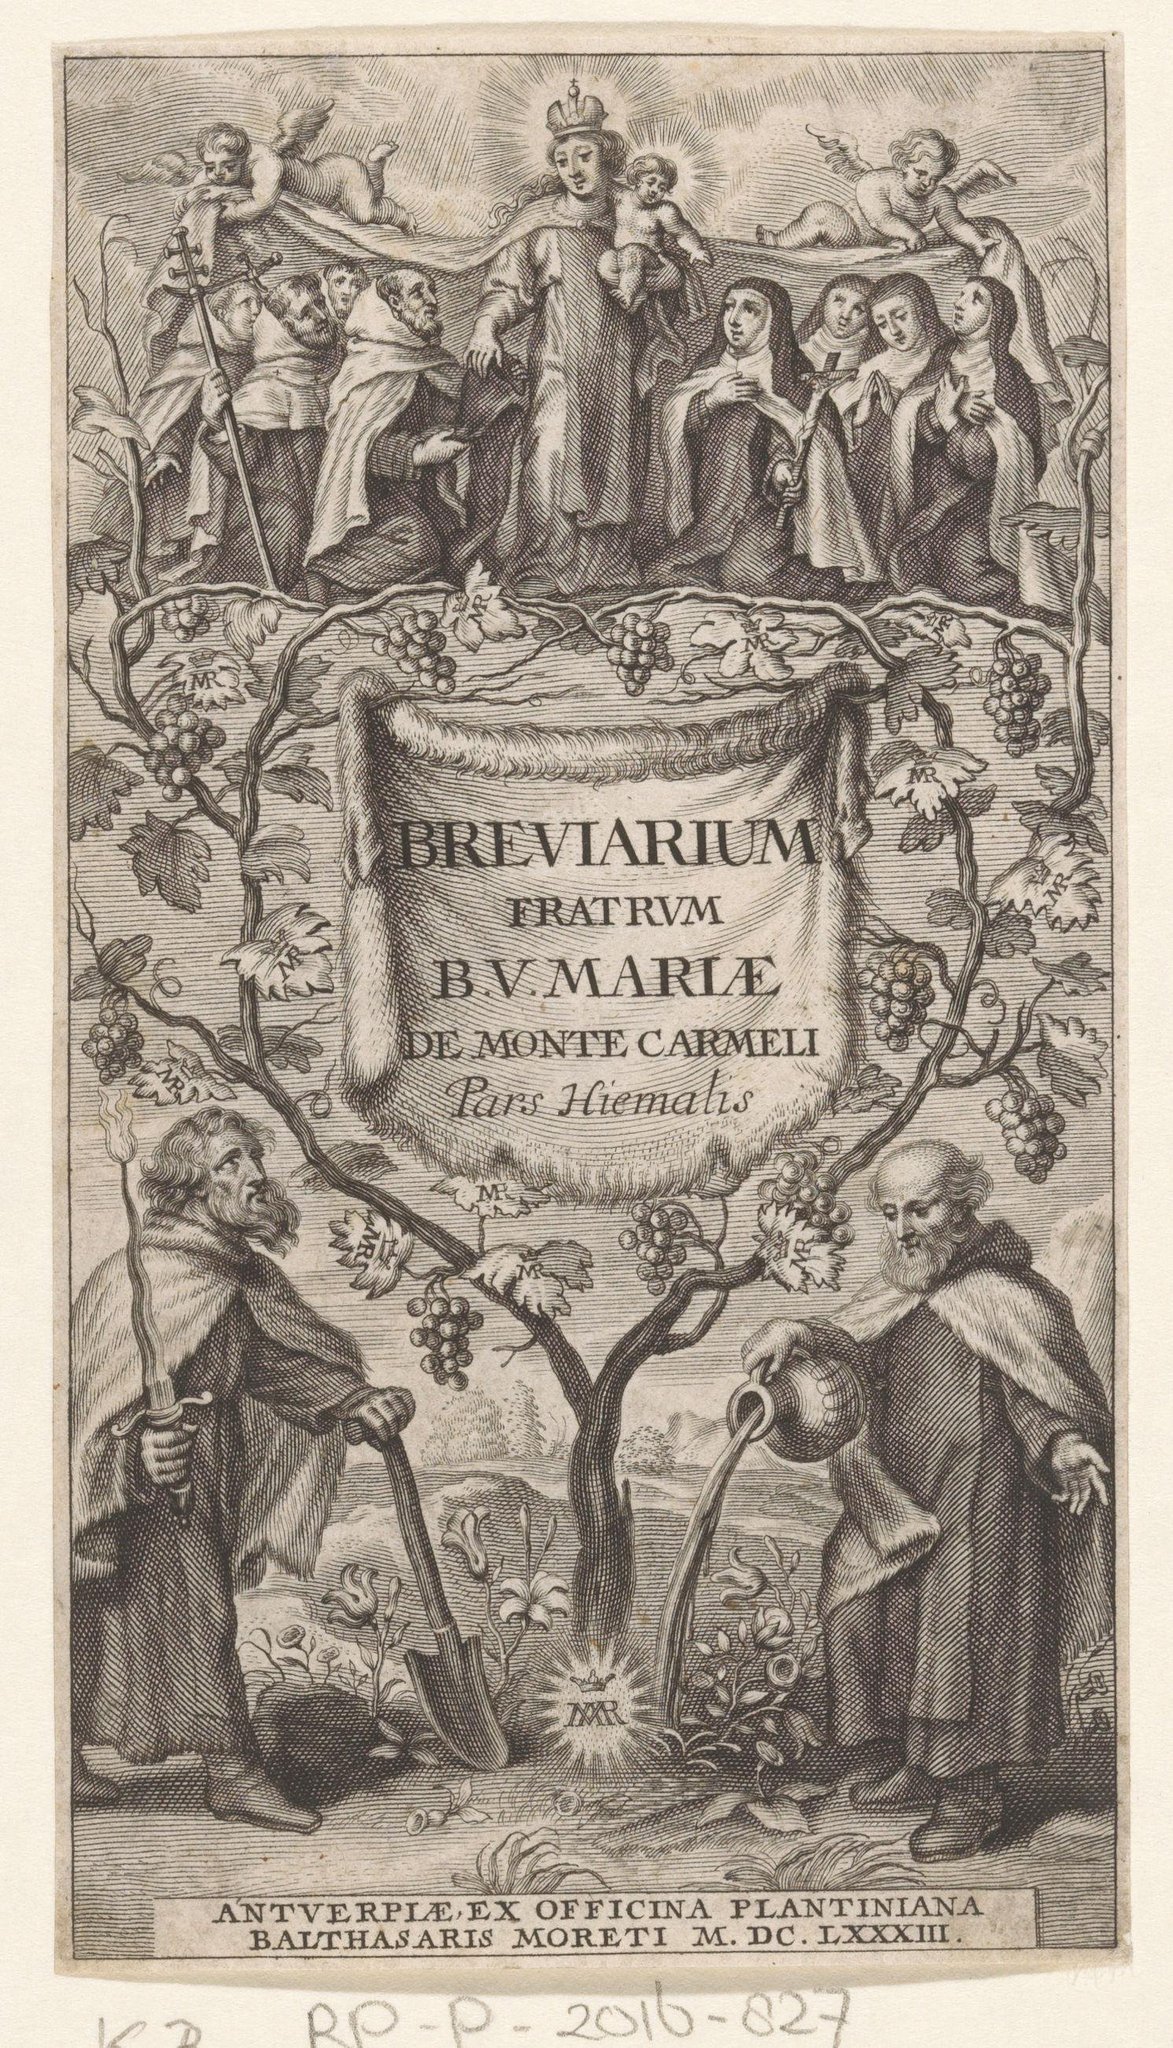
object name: print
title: Karmelieten bij wijnrank met Madonna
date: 1683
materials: paper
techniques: engraving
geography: antwerp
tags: vine-tendril, leaf, madonna: i.e. mary with the christ-child, monastic orders, monastic life: carmelites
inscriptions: collector's mark: Lugt 240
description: Twee Karmelieten staan met een brandend zwaard en een waterkruik bij wijnranken met een doek met de titel van het boek. Daarboven wordt Madonna aanbeden door geknielde broeders en zusters.